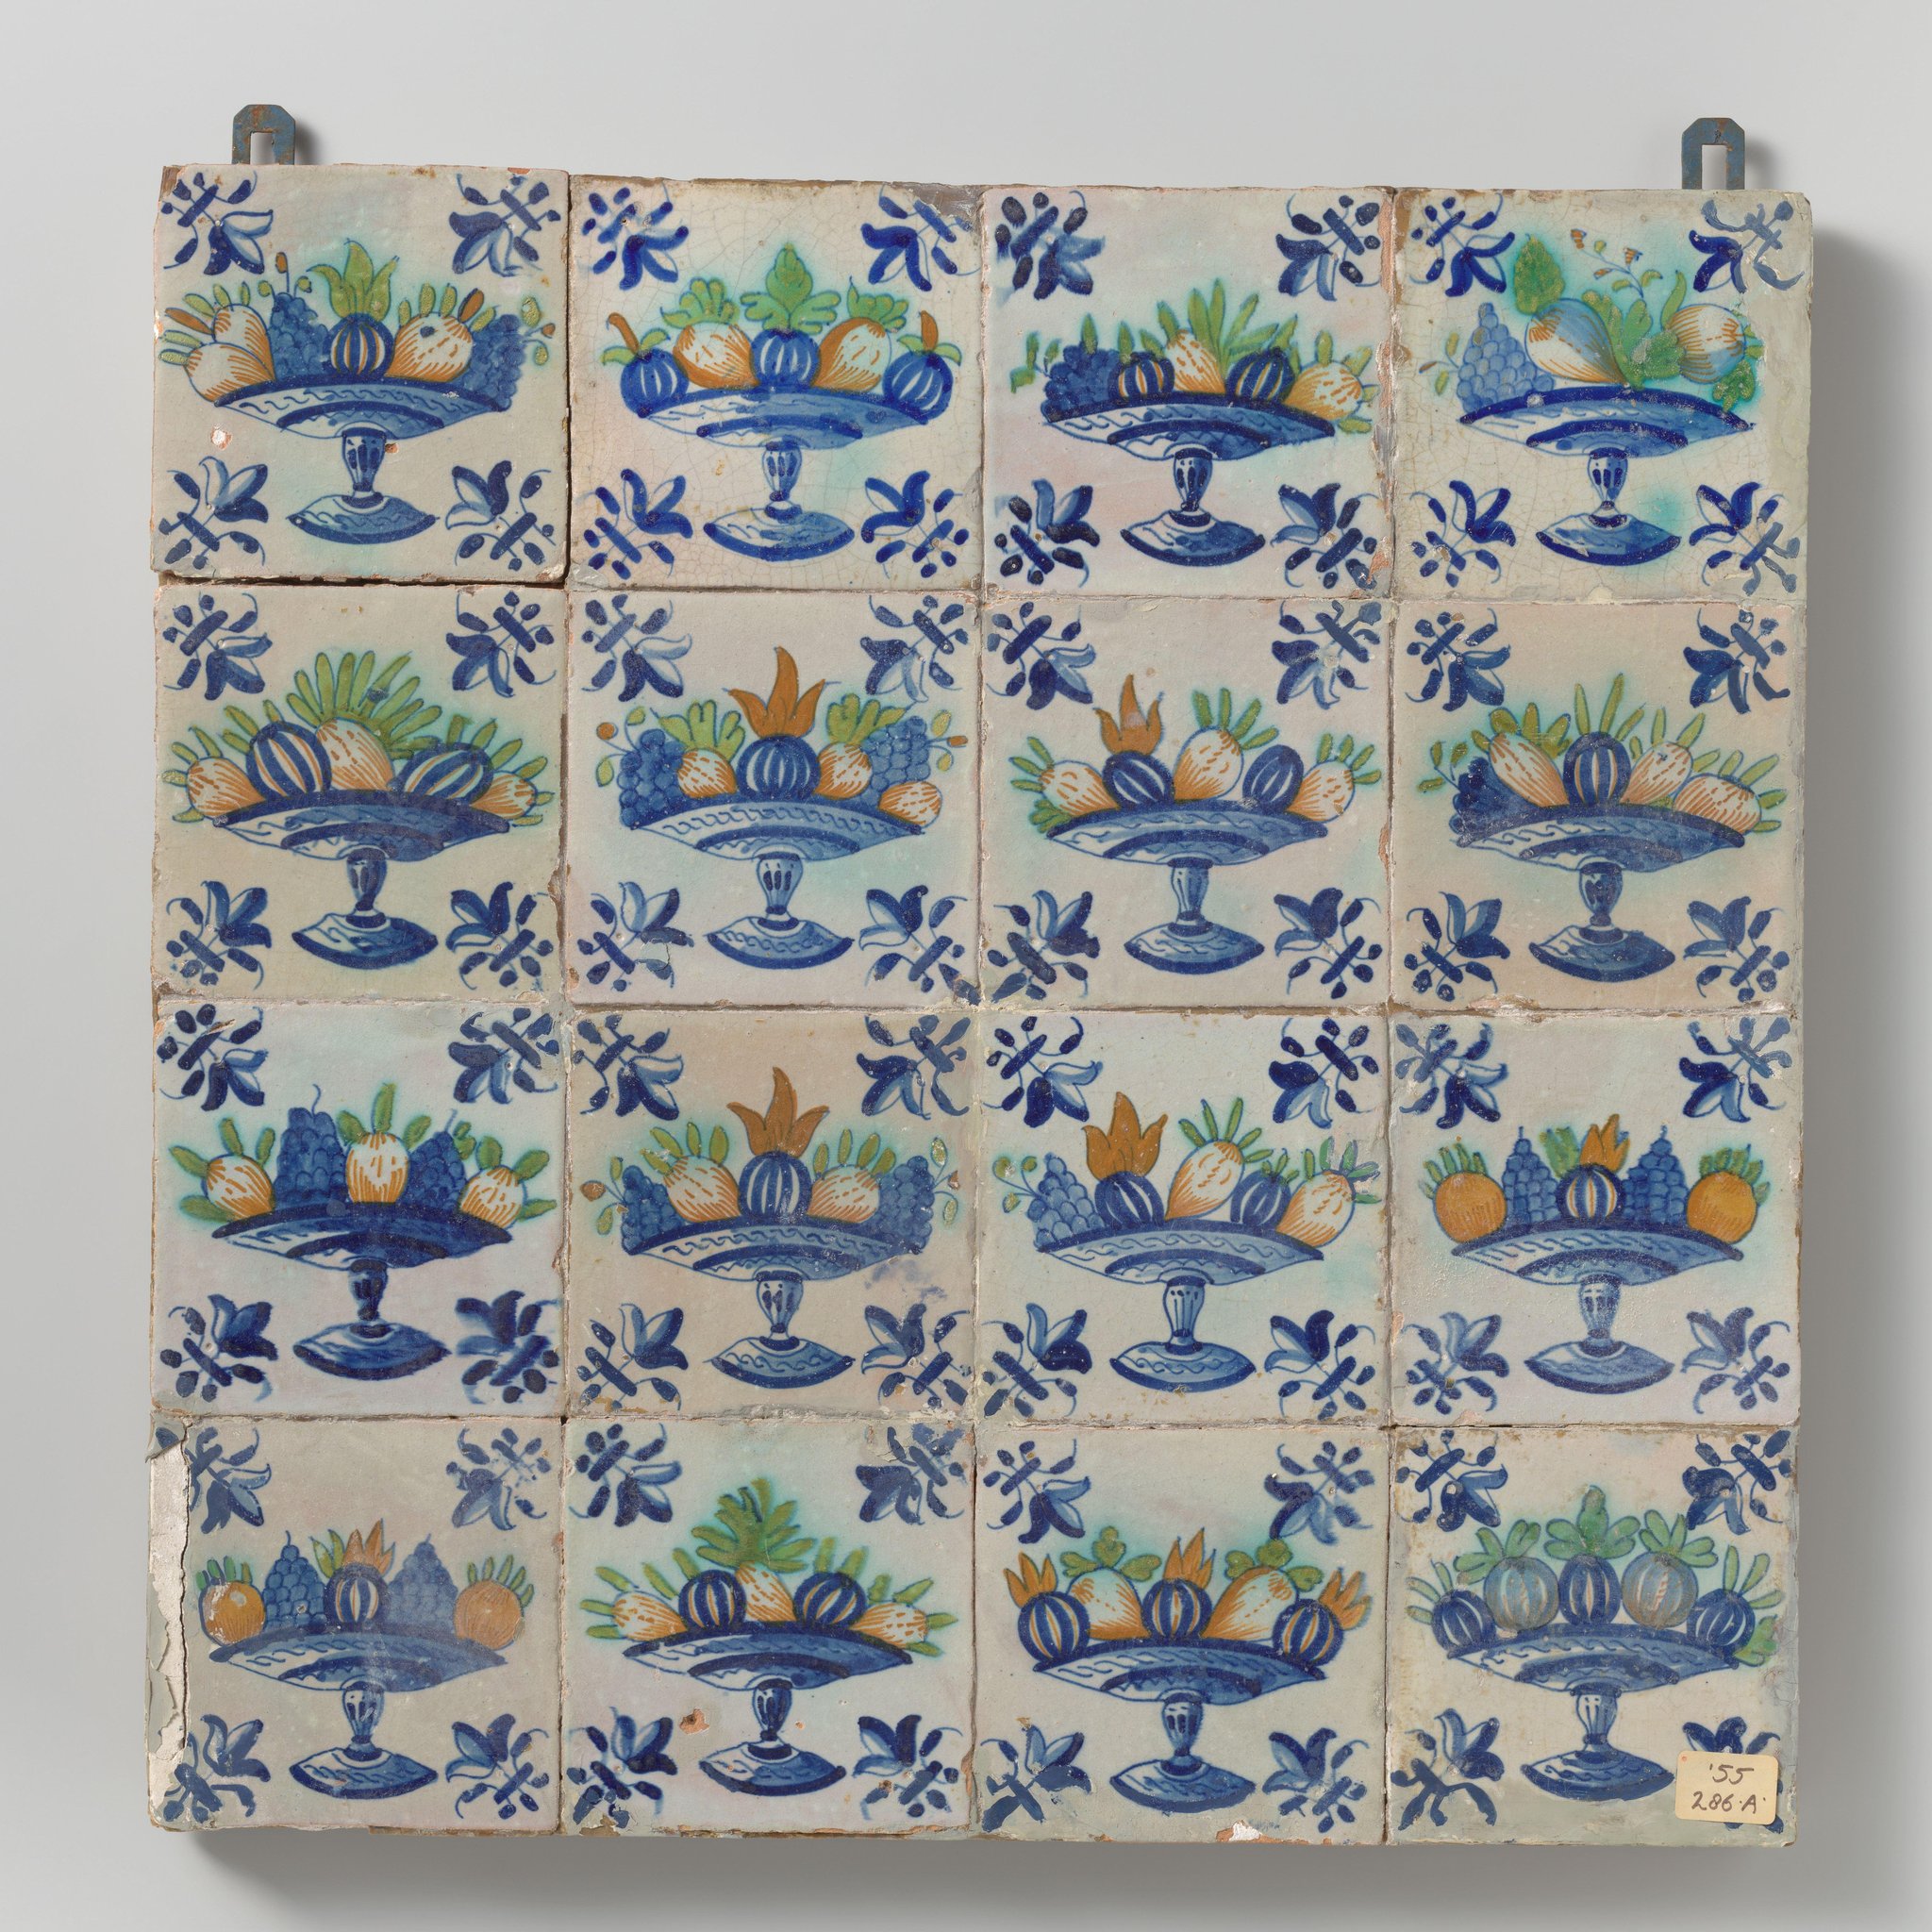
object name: tile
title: Tegel met fruitschaal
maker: Anonymous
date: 1640-1660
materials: earthenware, glaze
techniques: maiolica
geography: netherlands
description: Onderdeel van een veld van zestien tegels (4 x 4), zie BK-1955-286-A.